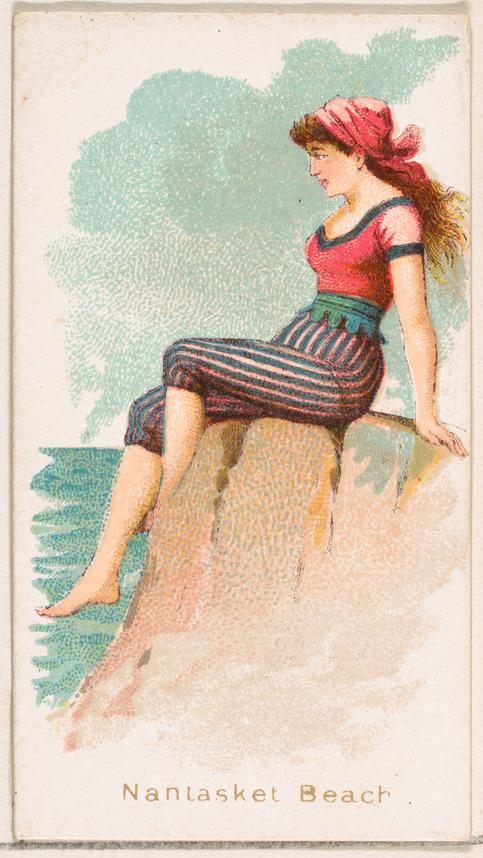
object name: print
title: Nantasket Beach, from the Fancy Bathers series (N187) issued by Wm. S. Kimball & Co.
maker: william s. kimball & company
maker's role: publisher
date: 1889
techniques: color lithograph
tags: profiles,women